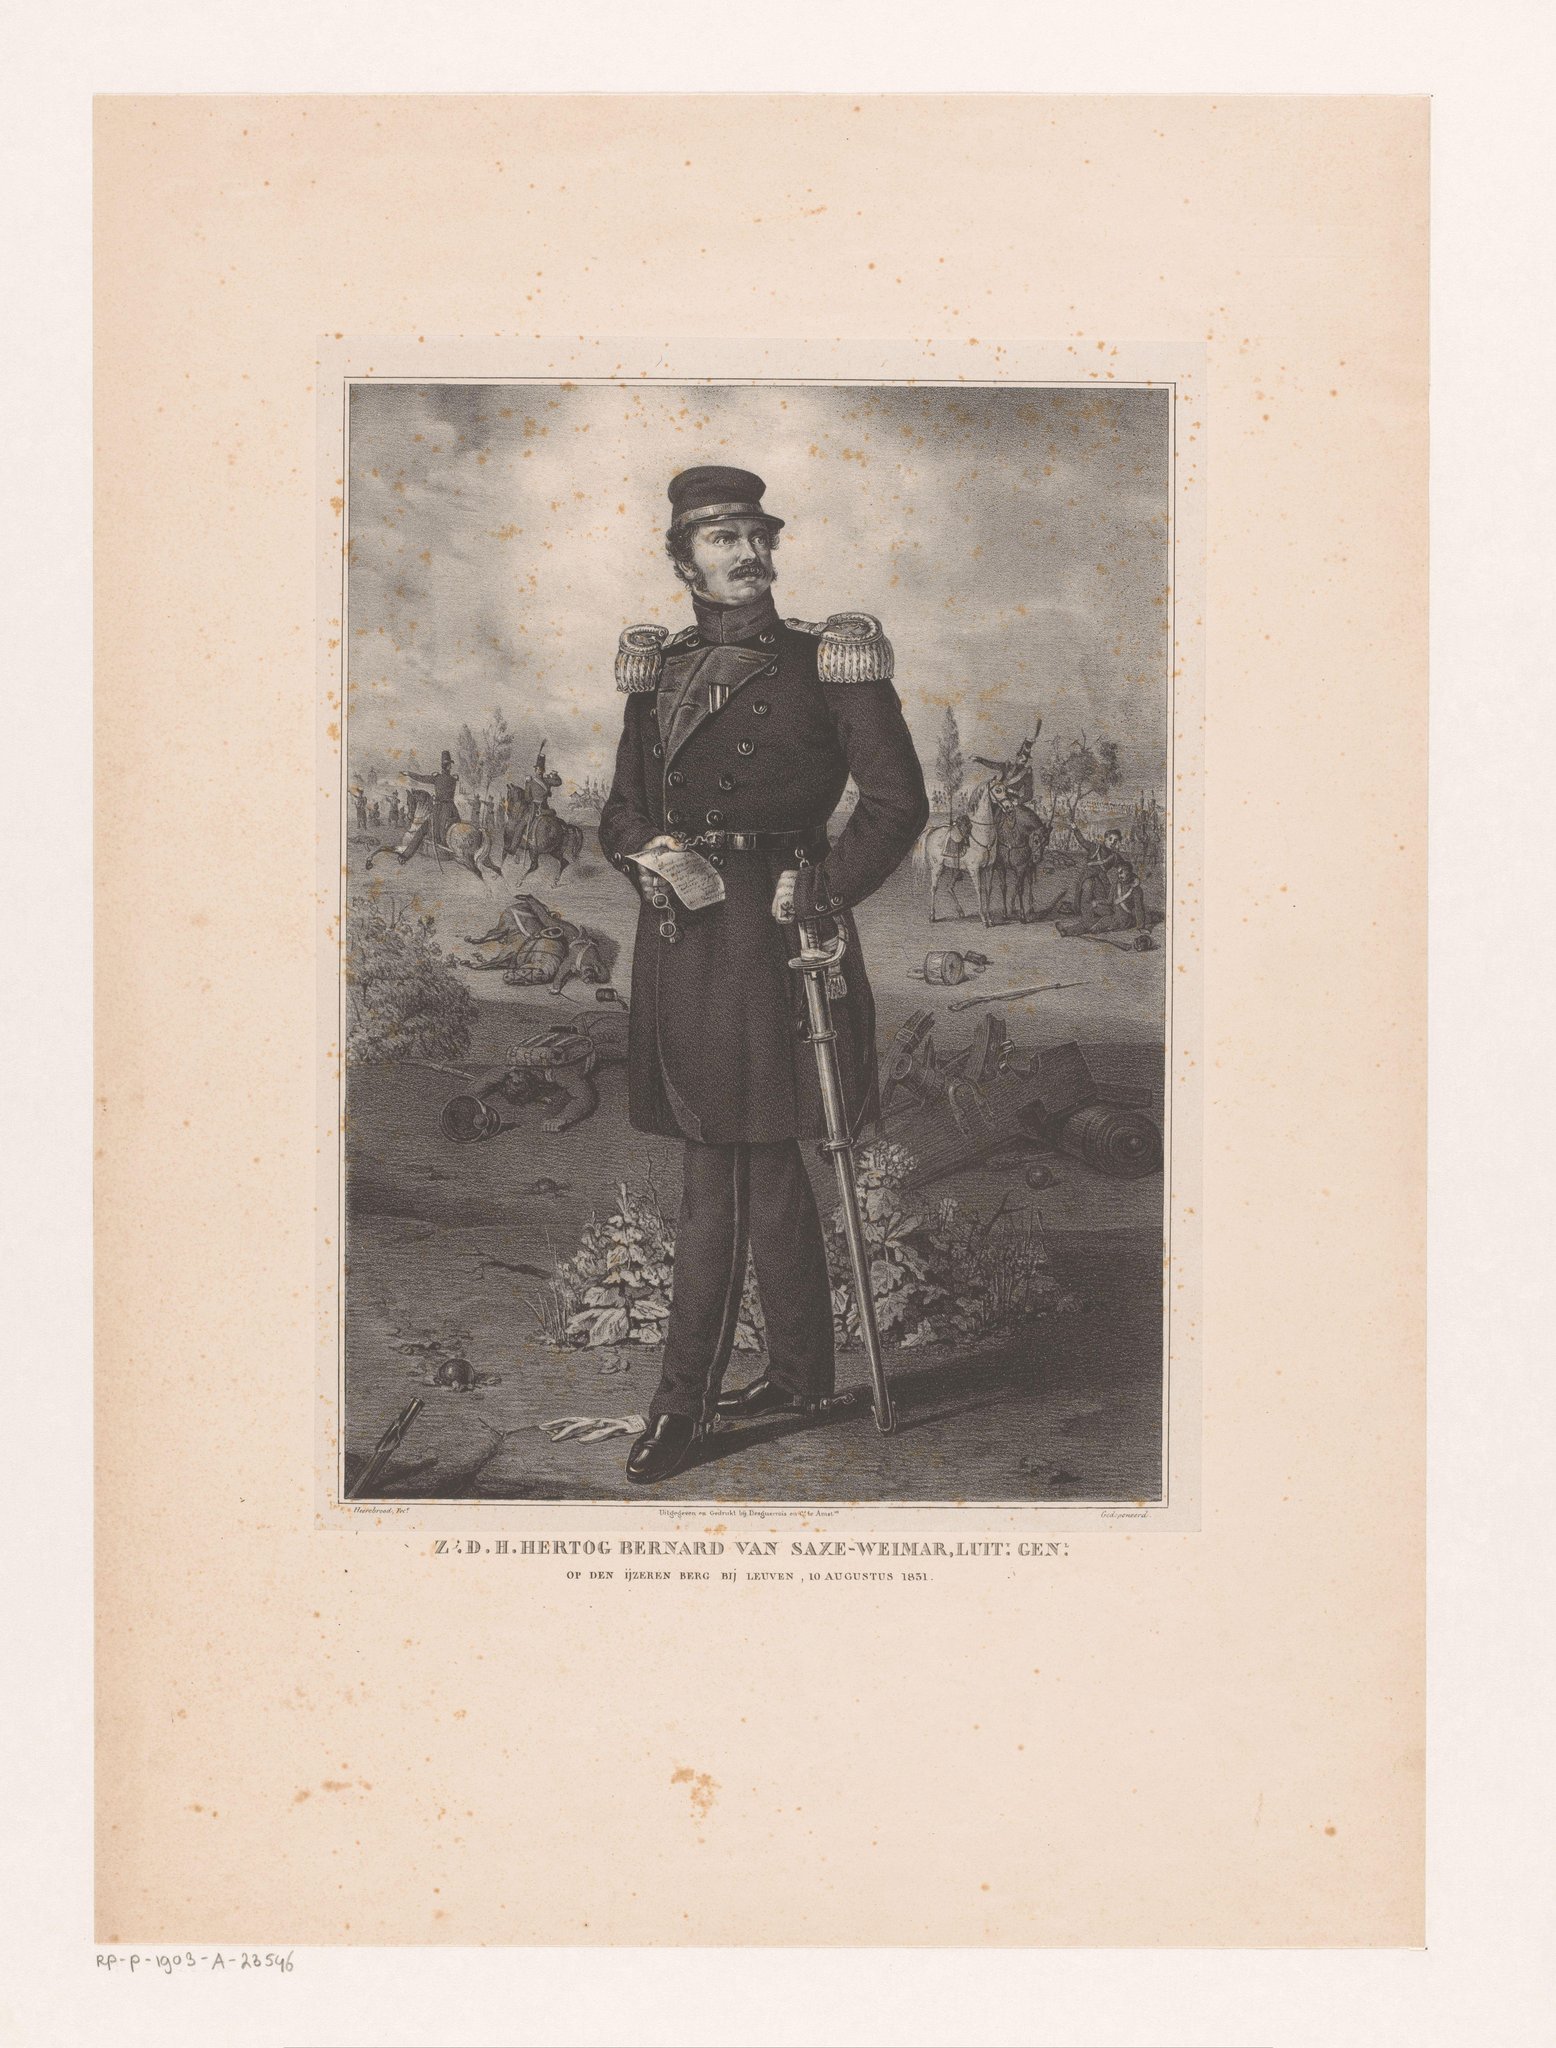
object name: print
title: Portret van luitenant generaal Bernard van Saksen-Weimar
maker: hendrik jan heerenbrood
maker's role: print maker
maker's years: 1787-1833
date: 1831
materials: paper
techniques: lithograph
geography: amsterdam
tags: karel bernhard (hertog van saksen-weimar-eisenach), eyeglasses, spectacles, commander-in-chief, general, marshal, carrying the sick, wounded and dead off the battle-field, letter, envelope, historical persons (+ three-quarter length portrait), louvain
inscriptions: collector's mark: Lugt 2228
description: De geportretteerde staat op de IJzeren brug bij Leuven. Achter hem een slagveld met dode en gewonden soldaten. Hij draagt een militair uniform. In zijn rechterhand heeft hij een brief en een bril.